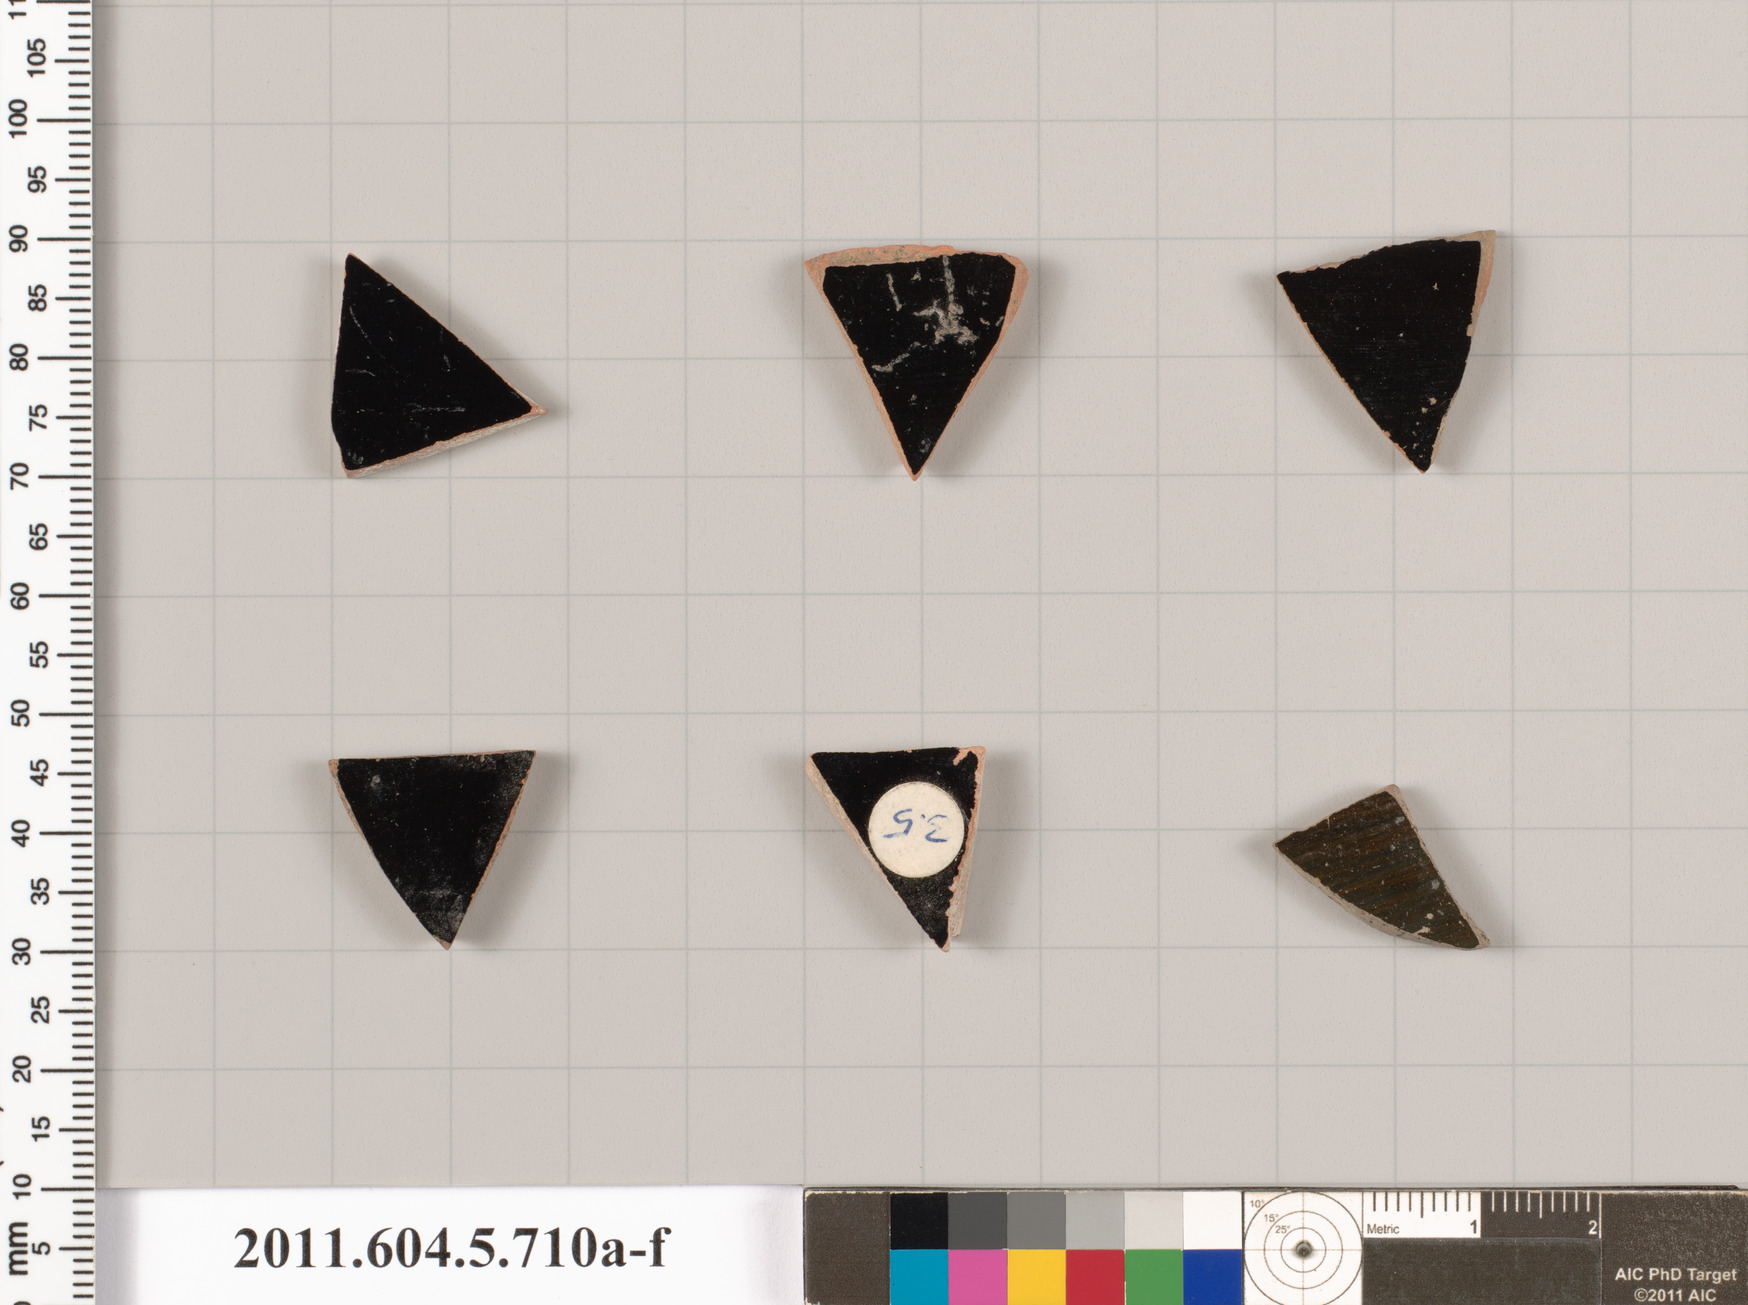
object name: kylix fragment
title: Terracotta fragments of kylikes (drinking cups)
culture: greek, attic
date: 600-401 BCE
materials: terracotta